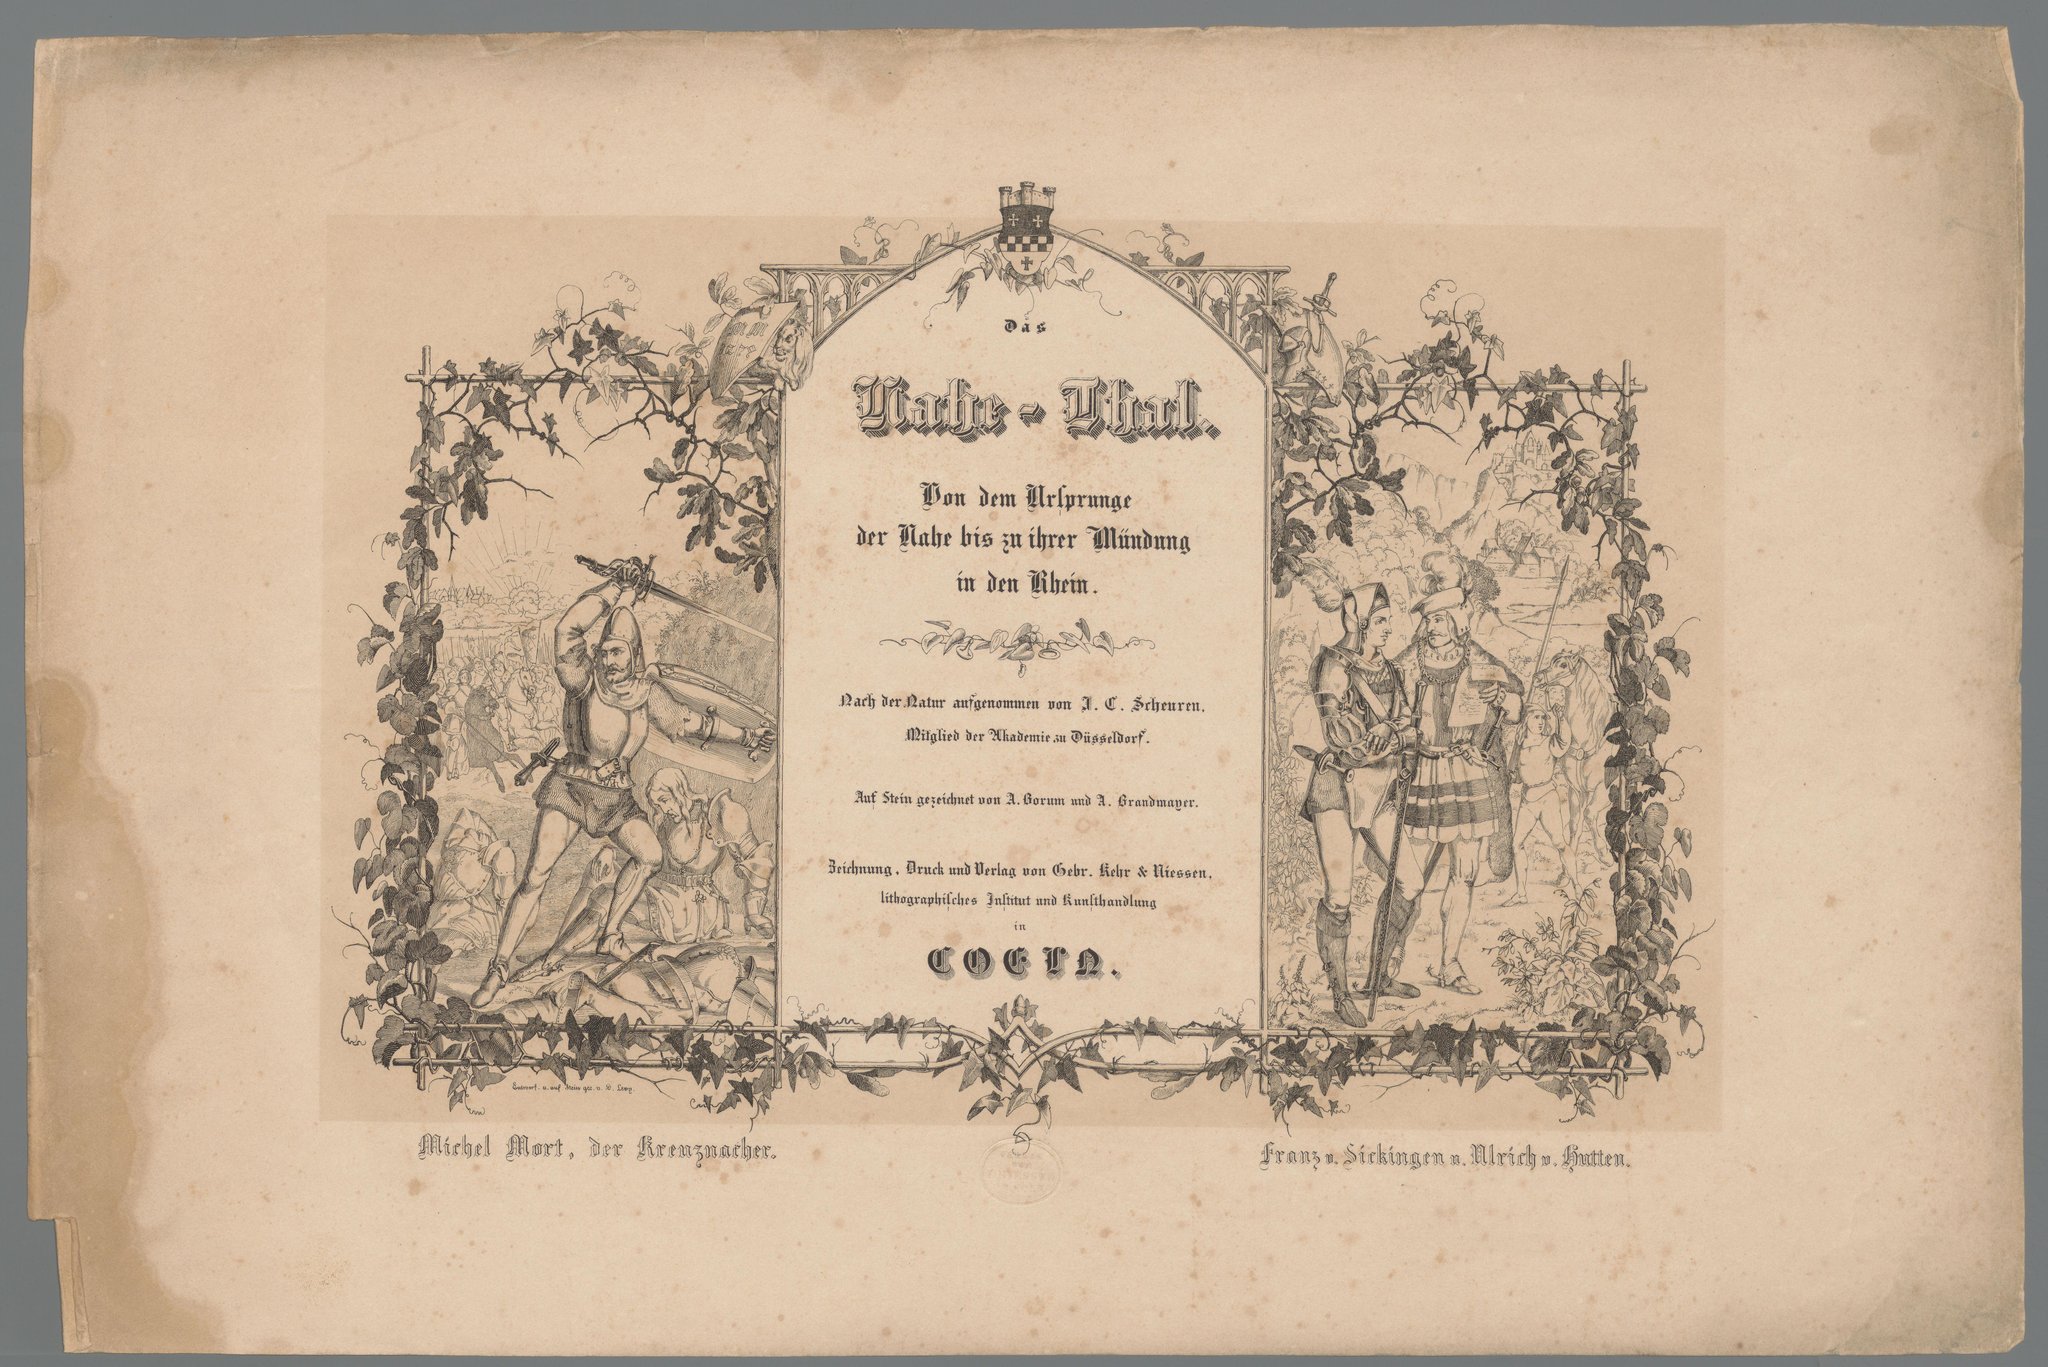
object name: print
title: Gezichten op het Nahe dal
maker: levy elkan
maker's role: print maker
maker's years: 1808-1865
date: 1834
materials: paper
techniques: tone lithography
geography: cologne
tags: switzerland, politician, weapons, landscape with tower or castle, knight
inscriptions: check stamp: ‘Verlag von I. Niessen Coeln’, collector's mark: Lugt 2228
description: De serie 'Das Nahe-Thal. Von dem Ursprunge der Nahe bis zu ihrer Mündung in den Rhein' is uitgegeven in vijf delen van elk vier prenten vervaardigd door A. Brandmayer en Andreas Borum. Tien prenten uit deze serie zijn daarnaast waarschijnlijk ook nog samen onder de titel 'Kreuznach und seine Umgebung. Erinnerung an seine Heilquellen und das Nahe-Thal' uitgegeven.